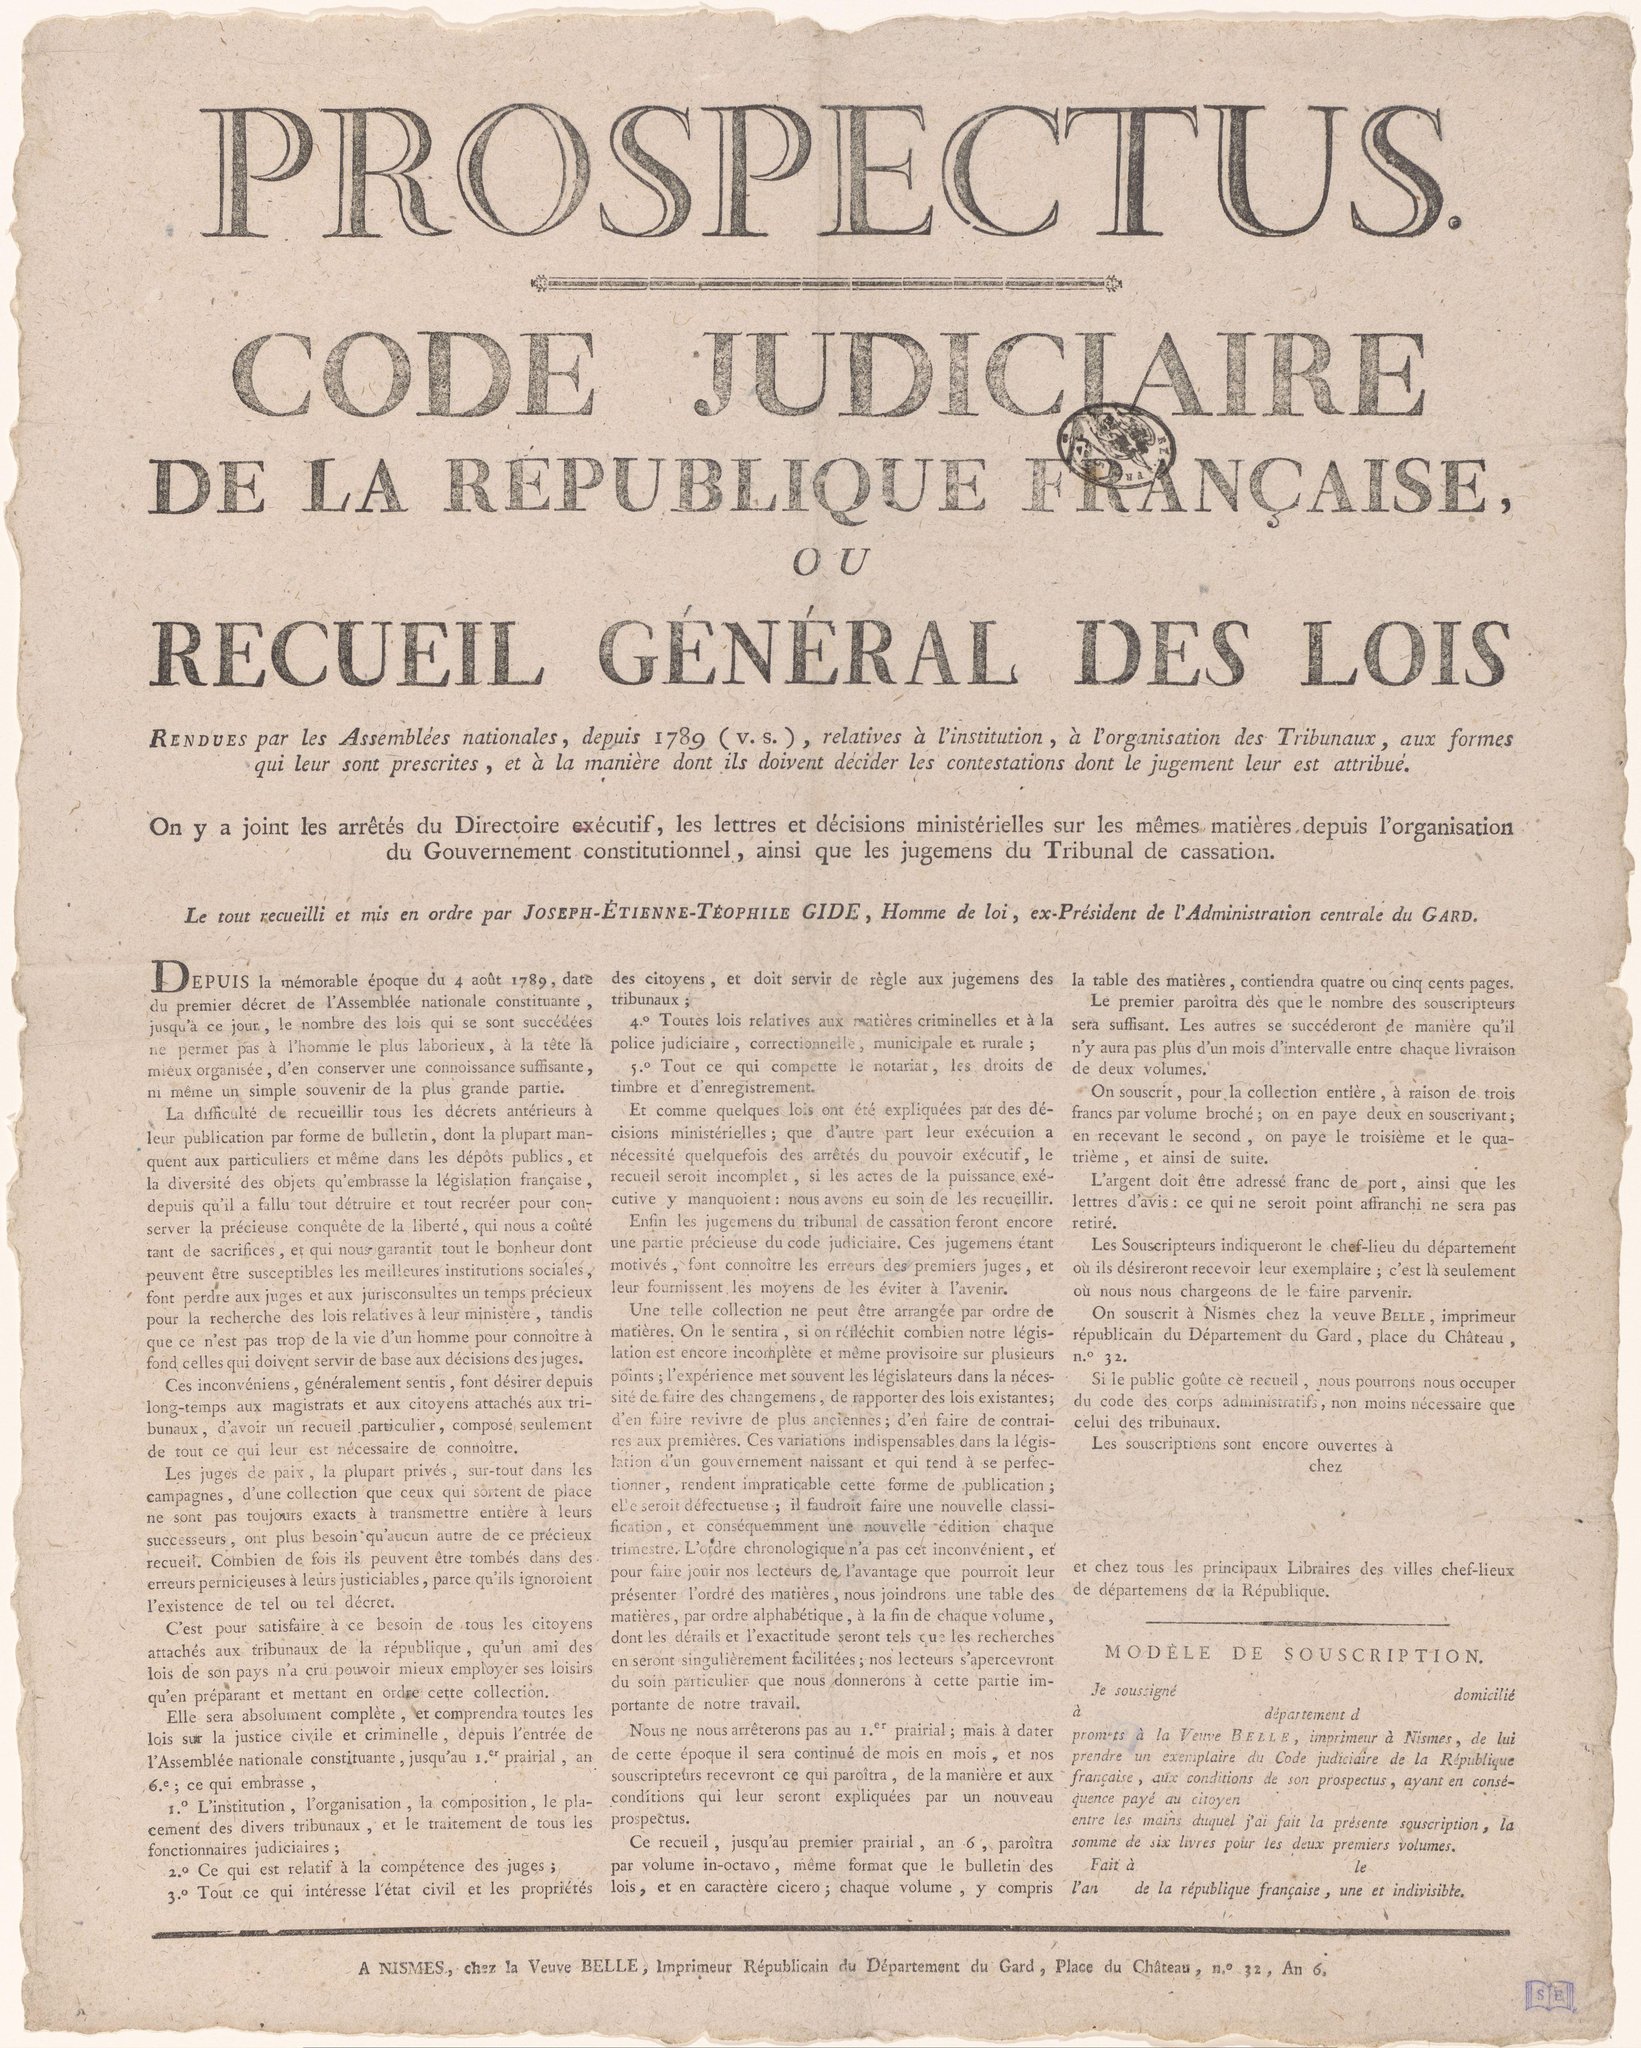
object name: print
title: Uitgeversprospectus voor de Code judiciaire de la République française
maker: veuve de coste belle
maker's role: printer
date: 1797-1798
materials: paper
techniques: letterpress printing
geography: nîmes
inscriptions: collector's mark: Lugt 4779, collector's mark: Lugt 2228, stamp, collector's mark: Lugt 4779